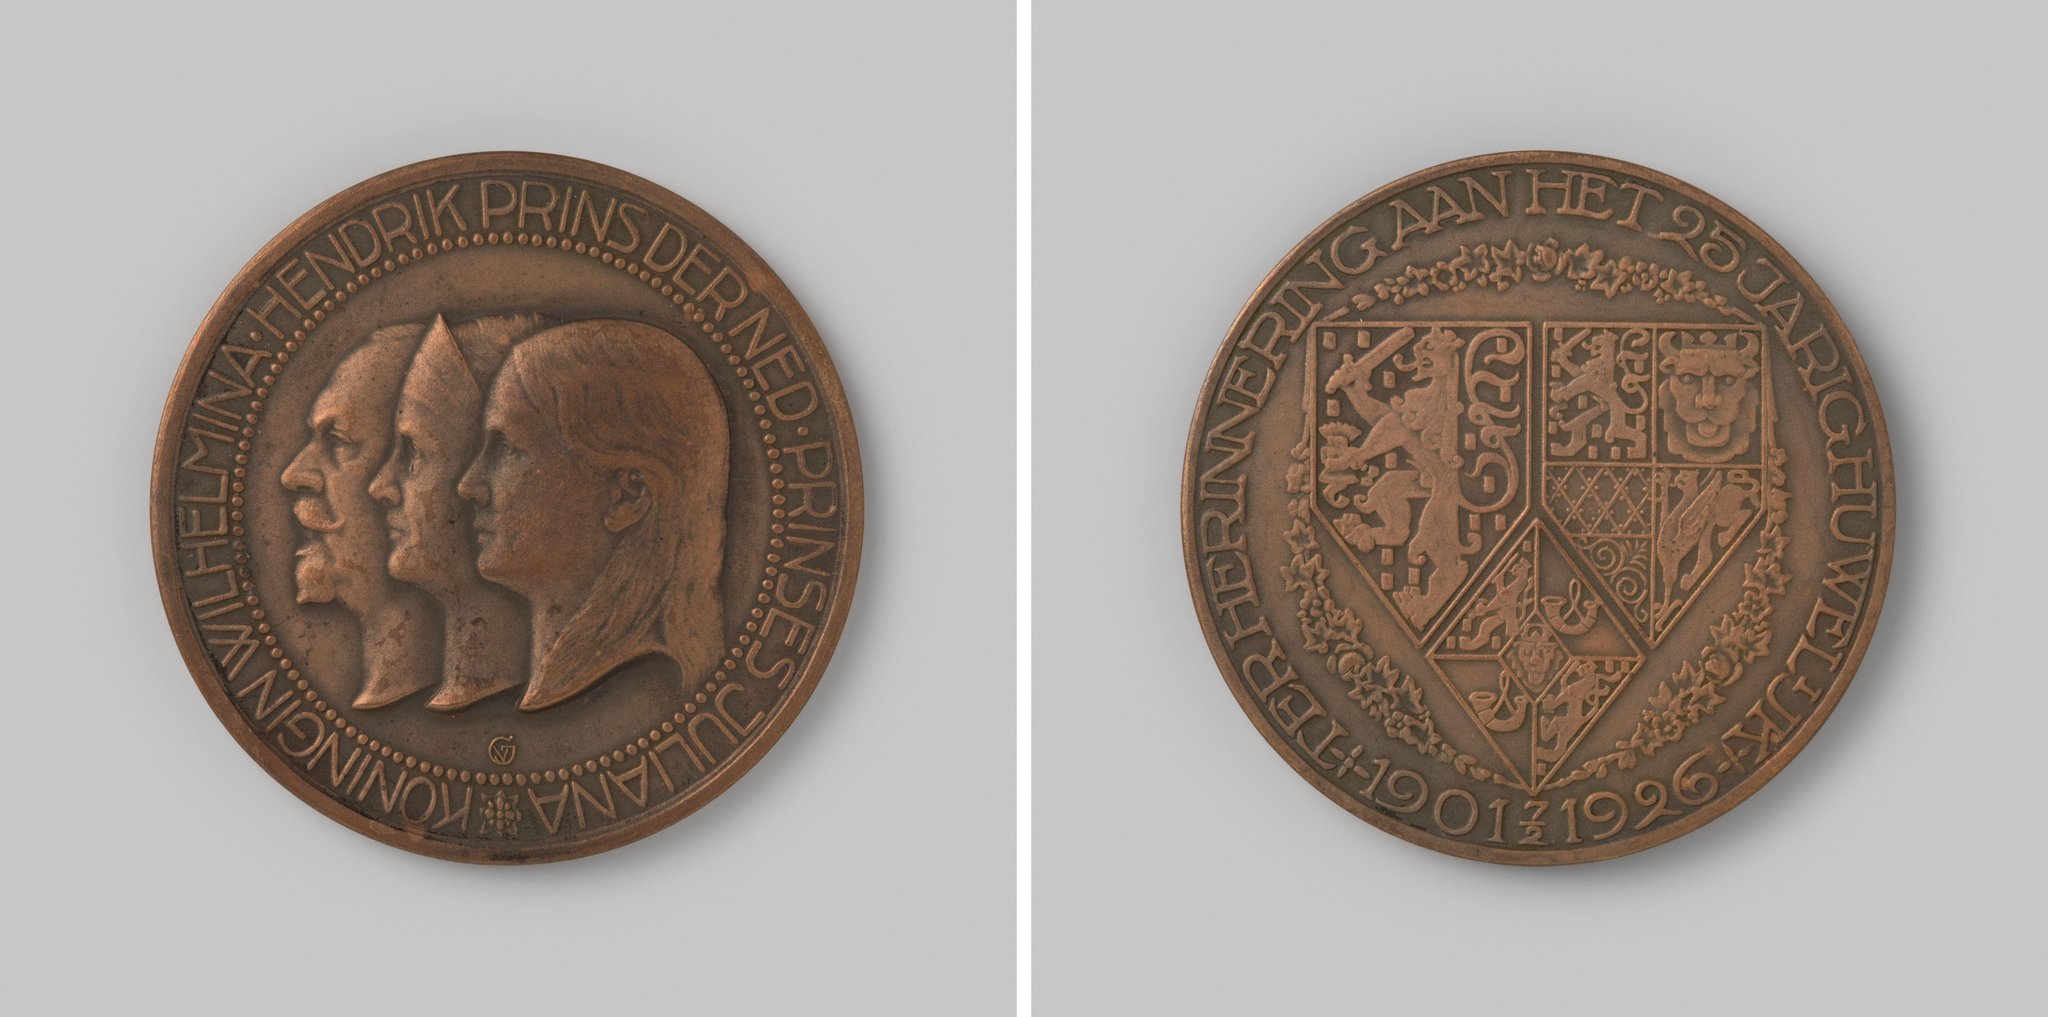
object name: history medal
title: Vijfentwintigjarig huwelijk van Koningin Wilhelmina en Prins Hendrik 1926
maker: jacob jan van goor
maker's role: medailleur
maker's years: 1874-1956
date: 1926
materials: bronze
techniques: striking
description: Bronzen penning, op de voorzijde de geconjugeerde portretten van Hendrik, Wilhelmina en prinses Juliana naar links met omschrift, op de keerzijde de in een driehoek aaneengelegde wapenschilden van Nederland, Hendrik en Juliana binnen een klimopkrans, met omschrift.